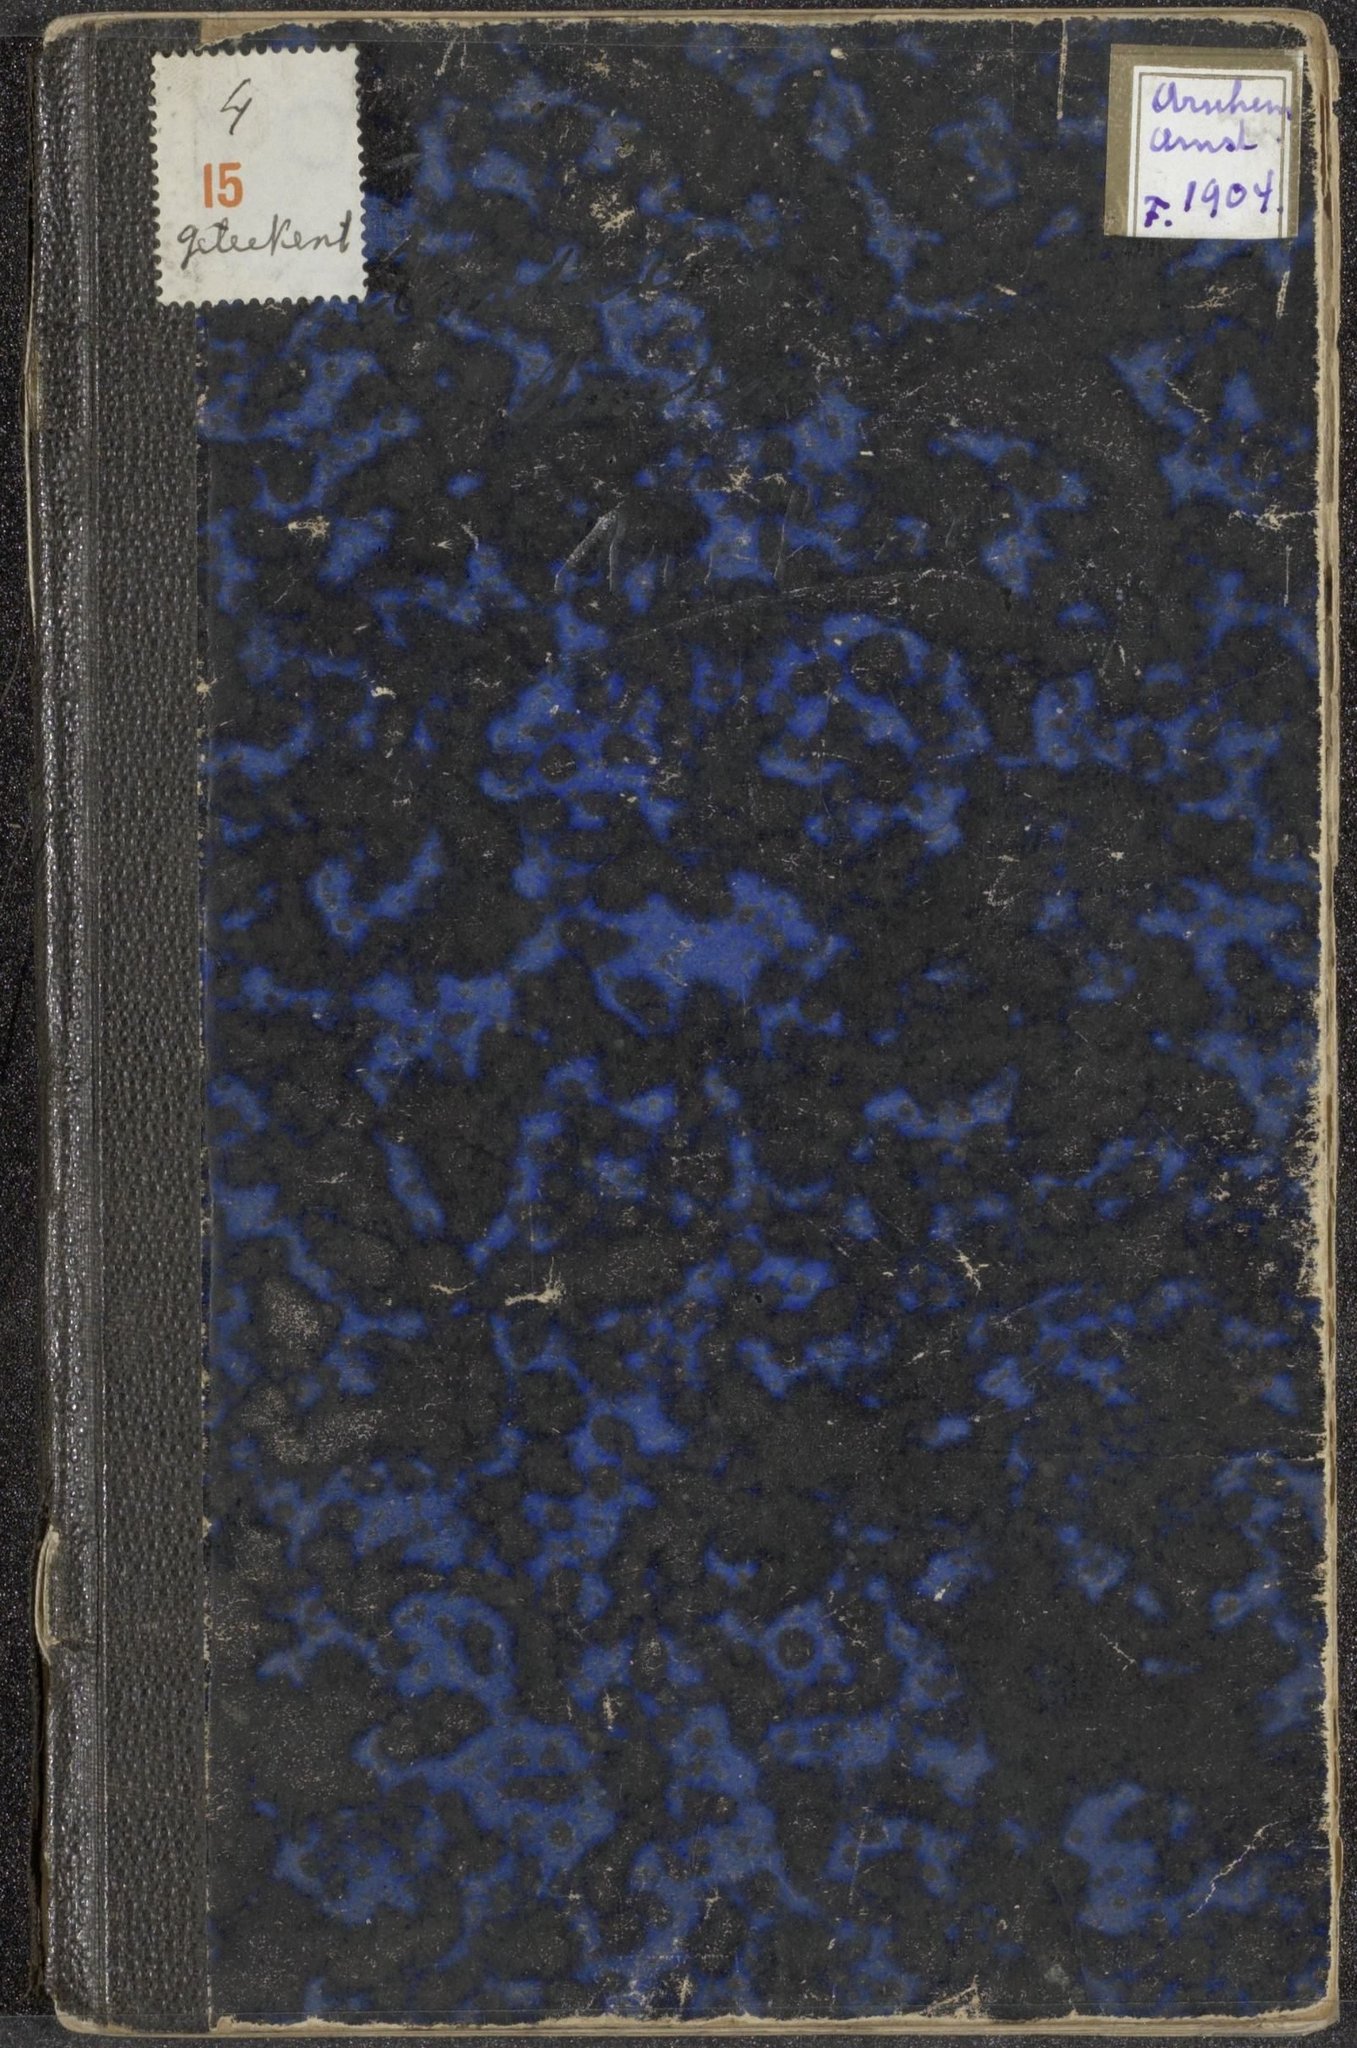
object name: sketchbook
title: Schetsboek met 14 bladen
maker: george hendrik breitner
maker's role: draughtsman, painter, print maker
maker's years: 1857-1923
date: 1904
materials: cardboard, chalk, linen, paper, pencil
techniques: marbling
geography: arnhem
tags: landscapes in the temperate zone, horse, public road, amsterdam, arnhem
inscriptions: workshop stamp: Lugt 291d, annotation: ‘Amsterdam/ Arnhem/ Arnhem/ Arnhem/ Amst./ 1904./ F.’, collector's mark: Lugt 2228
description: Schetsboek bestaande uit 14 bladen met landschappen, paarden, figuurstudies en gezichten te Amsterdam en Arnhem.